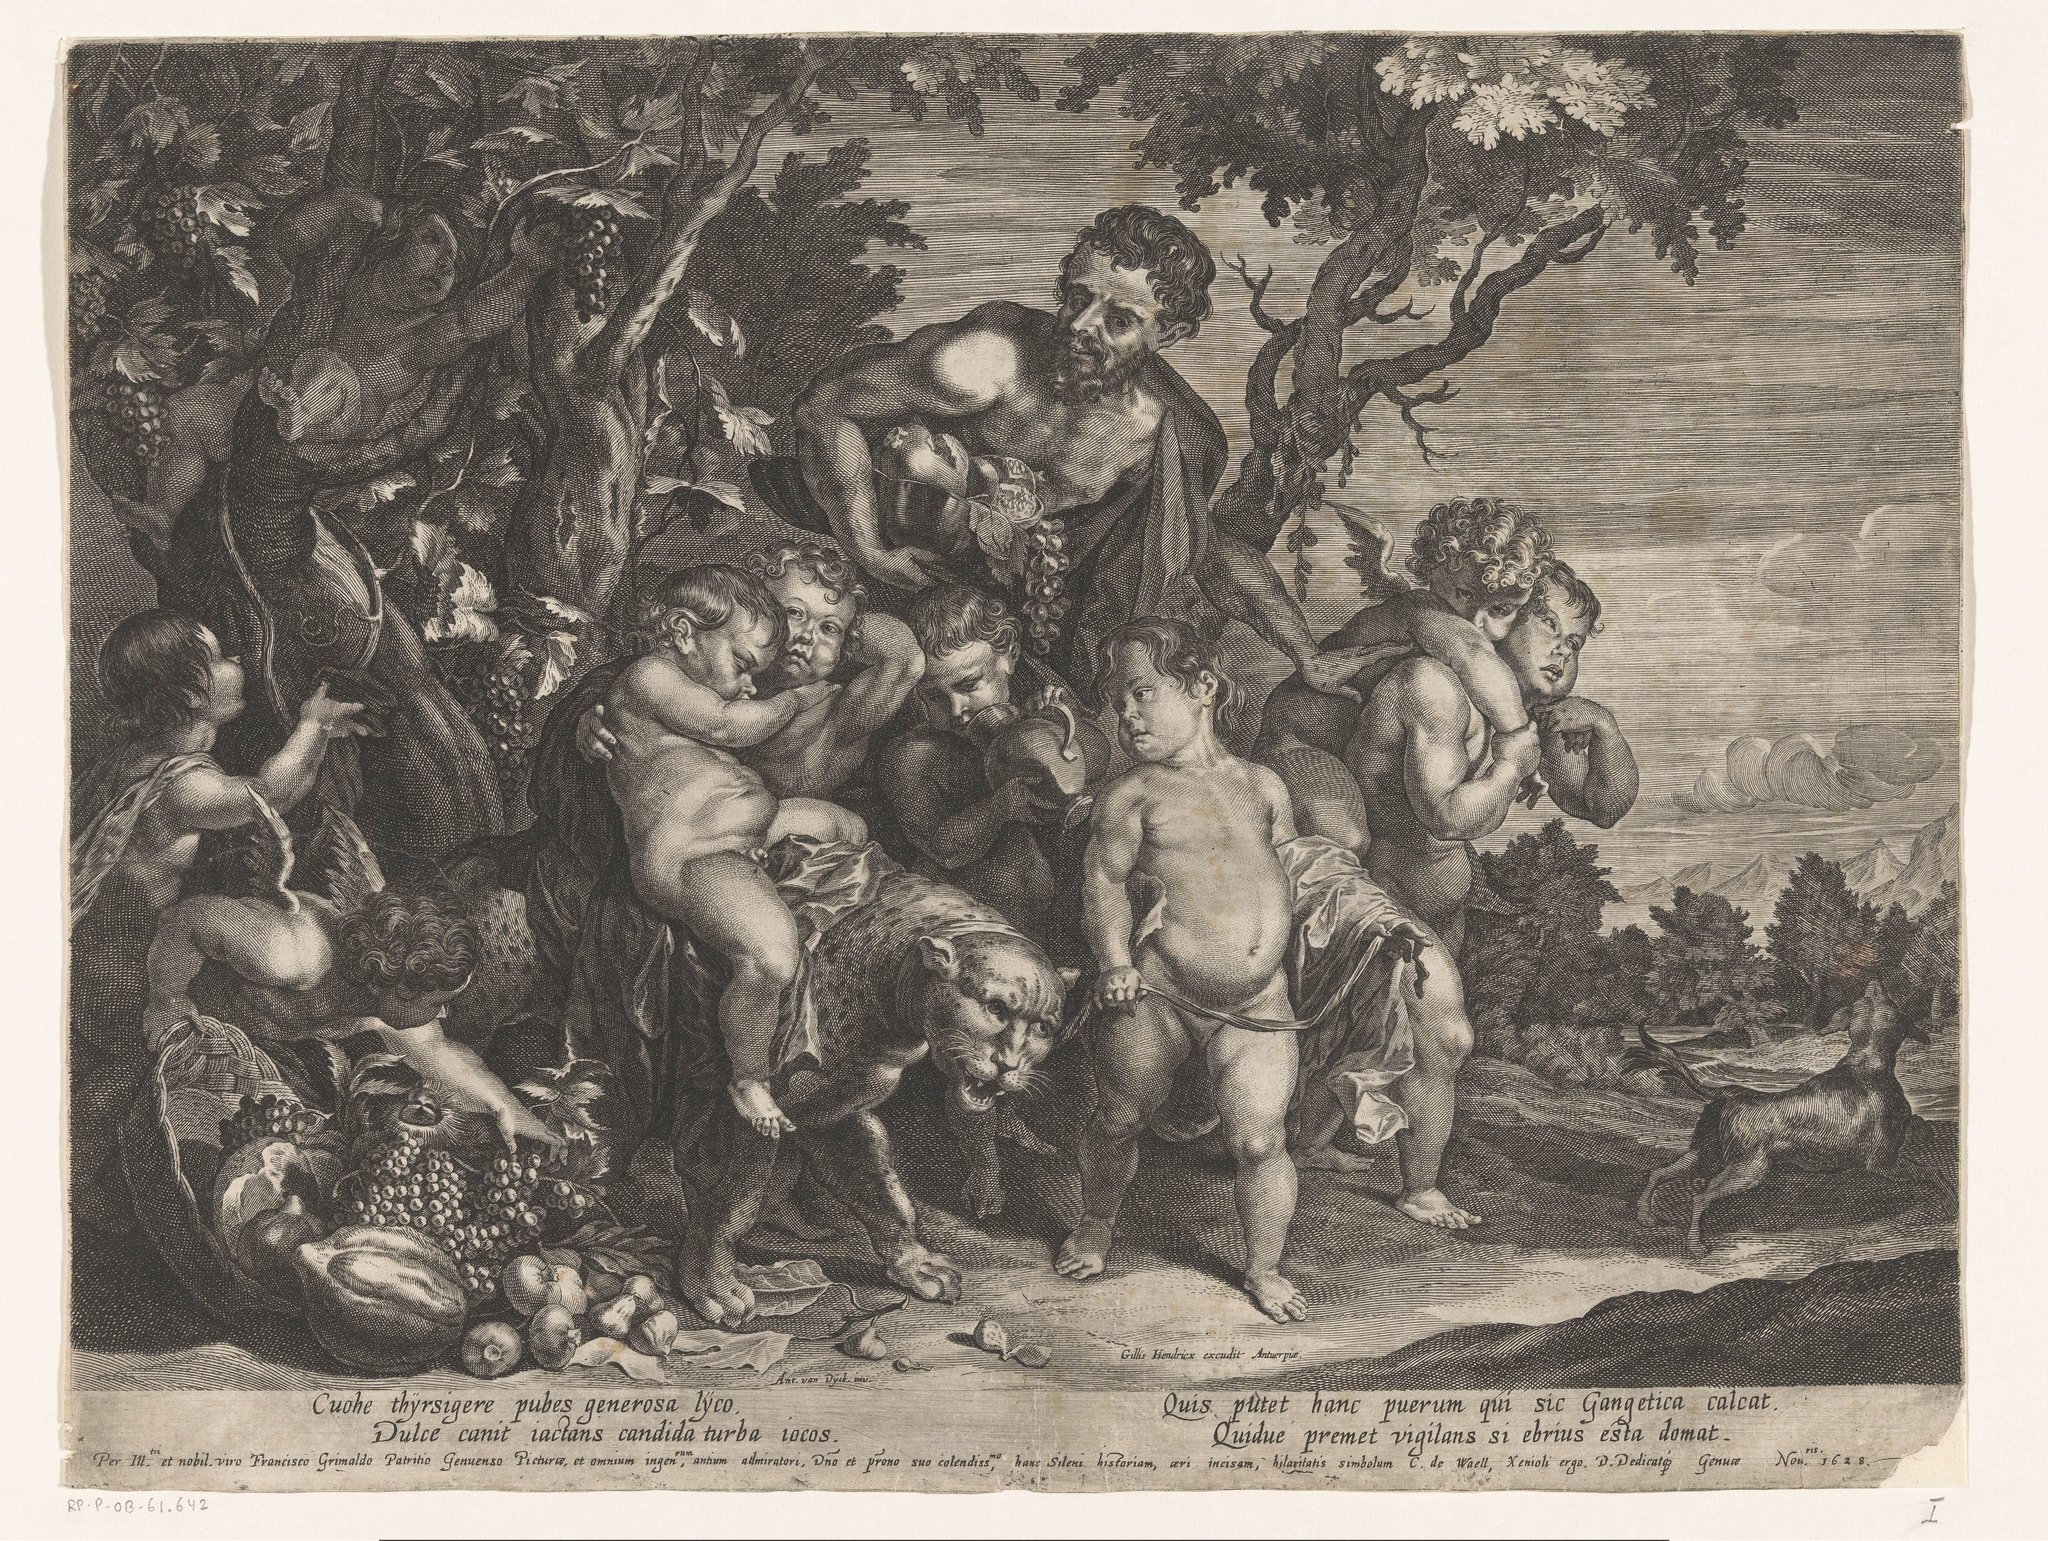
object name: print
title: Triomf van Bacchus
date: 1611-1628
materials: paper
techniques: engraving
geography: straatsburg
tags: beasts of prey, predatory animals: leopard, triumph of bacchus; 'carro di bacco' (ripa)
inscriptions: collector's mark: Lugt 2166